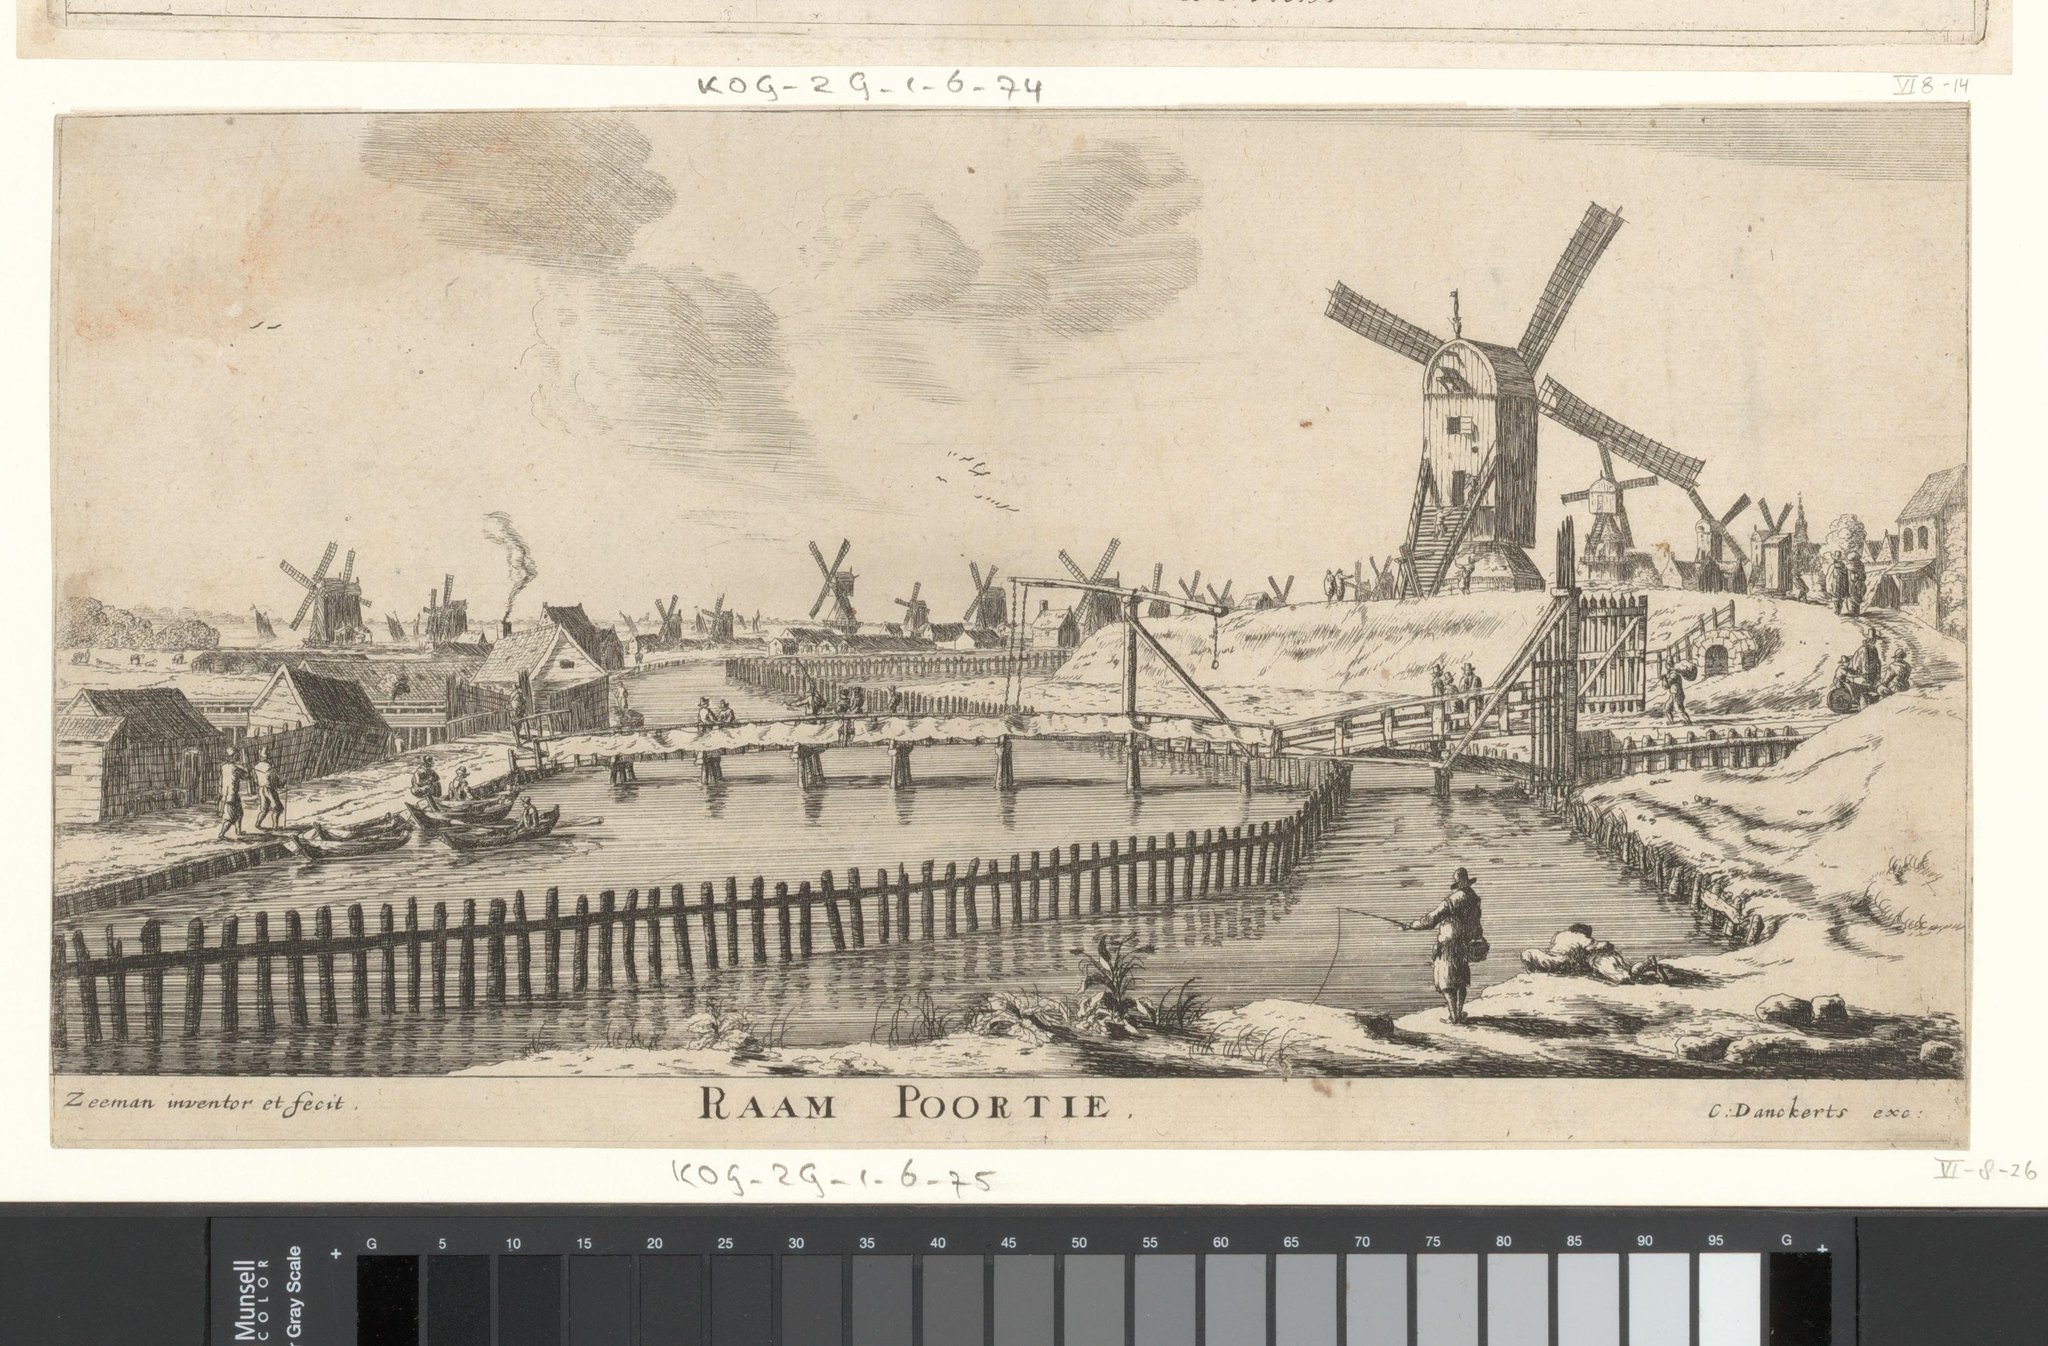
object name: print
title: Gezicht op de Raampoort te Amsterdam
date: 1654-1701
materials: paper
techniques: drypoint, engraving, etching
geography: amsterdam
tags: tower, clock tower ~ monumental adornment, windmill, city-gate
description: Onderdeel van een prentserie bestaande uit een titelprent en zeven prenten van Amsterdamse stadspoorten of alleen zeven (of zes) prenten van Amsterdamse stadspoorten. Van deze prentserie zijn drie uitgaven bekend, respectievelijk uitgegeven door Cornelis Danckerts (I), Dancker Danckerts en Justus Danckerts. Van de titelprent zijn drie staten bekend: één staat voor de letter waarop het droge naaldwerk nog goed zichtbaar is, één staat waarop Dancker Danckerts als uitgever vermeld staat; en één staat waarop Justus Danckerts als uitgever vermeld staat. De serie uitgegeven door Cornelis (I) Danckerts had mogelijk geen titelprent. Van elk van de overige prenten zijn redelijk wat exemplaren overgeleverd maar is telkens slechts één staat bekend. Op vier van deze prenten staat Cornelis Danckerts (I) vermeld als uitgever. Op twee prenten staat geen uitgever vermeld en op één prent staat Dancker Danckerts vermeld als uitgever. Mogelijk hebben zowel Dancker als Justus voor hun uitgave hun naam op de titelprent vermeld zonder de overige prenten bij te werken. Dat zou betekenen dat de prenten waarop Cornelis (I) staat vermeld als uitgever, ook later door zijn zoons Dancker en Justus kunnen zijn uitgegeven. En dat de prent waarop Danker vermeld staat als uitgever ook door Justus kan zijn uitgeven. Dat op de prent van de Derde Regulierspoort (RP-P-AO-27-15-2 en RP-P-1882-A-6003) wel - in een net andere stijl - de naam van Dancker Danckerts staat, zou verklaard kunnen worden doordat deze prent iets later, na het overlijden van Cornelis (I) in 1656, aan de serie is toegevoegd. De serie bevat namelijk ook een prent van de Tweede Regulierspoort (RP-P-AO-27-4-2 en RP-P-OB-20.579). Deze houten poort werd in 1654 afgebroken en vervangen door de stenen Derde Regulierspoort die in 1655 voltooid zou zijn.